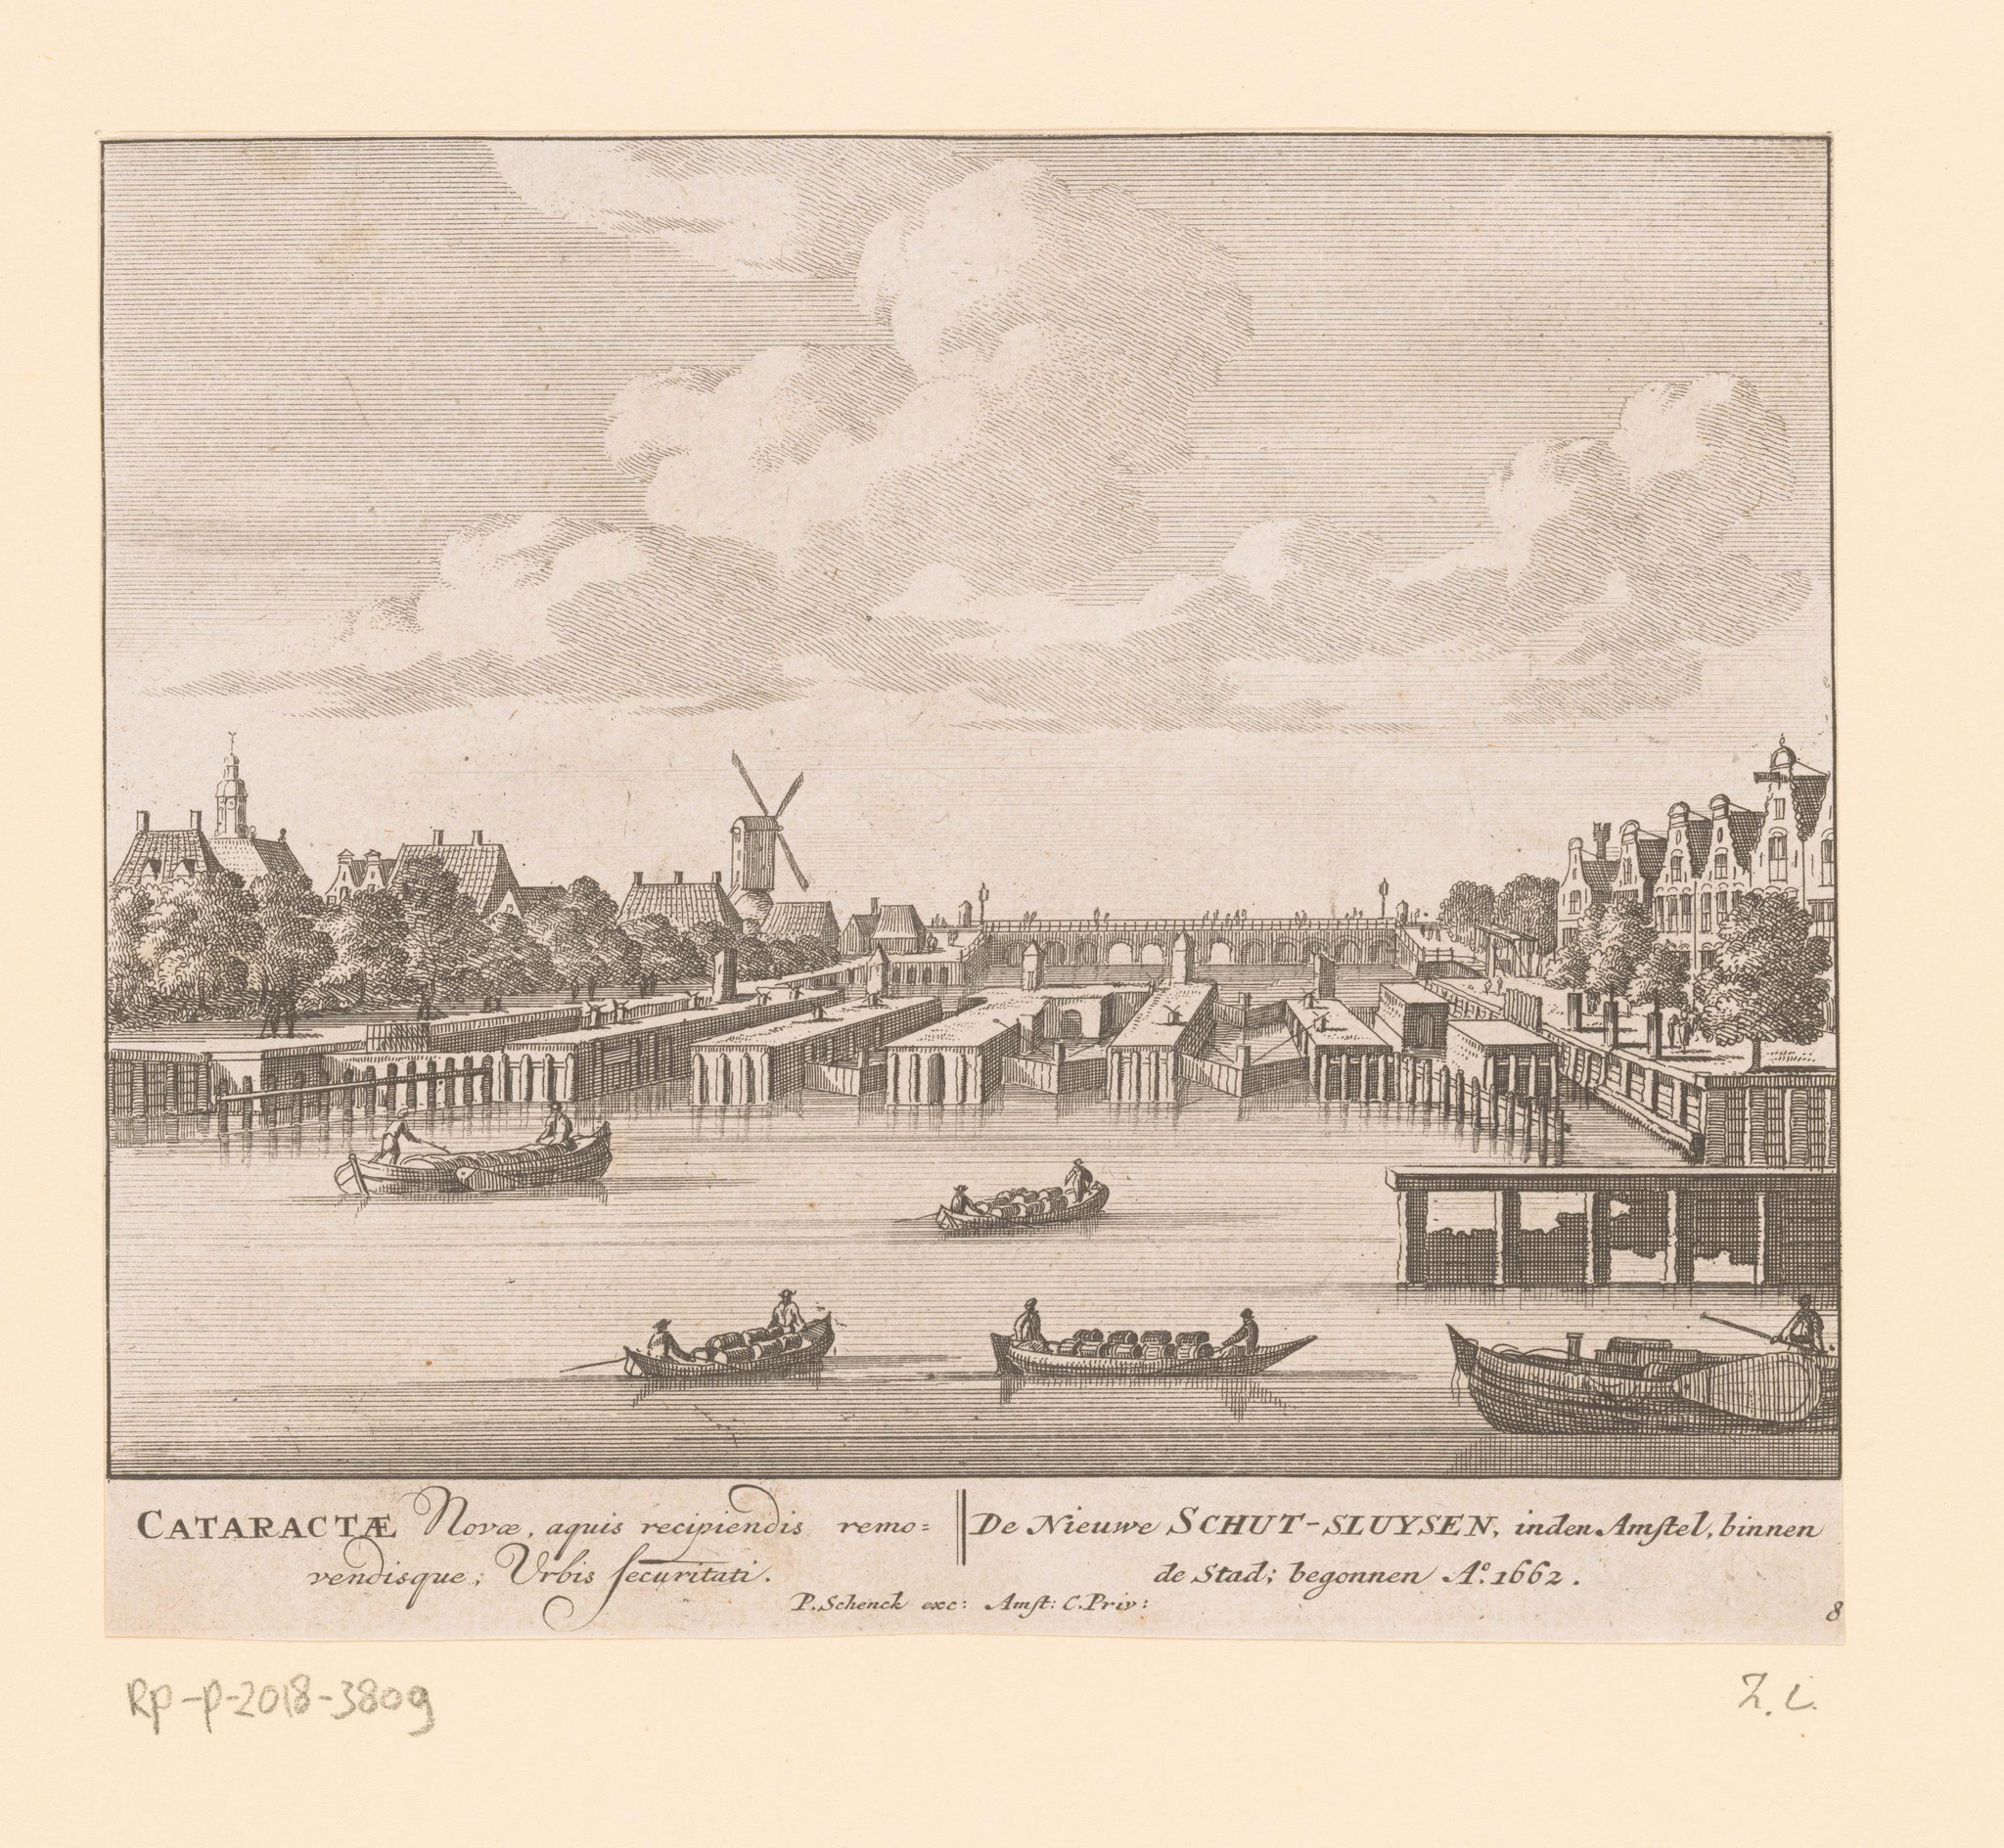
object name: print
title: Gezicht op de Binnen-Amstel en de Amstelsluizen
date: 1694-1697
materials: paper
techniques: etching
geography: amsterdam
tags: sluice, weir, city-view, and landscape with man-made constructions, canals, waters (in city)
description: Prent uit: Admirandorum Quadruplex Spectaculum. Amsterdam: Pieter Schenk (I), [1694-1697]. In Hollstein vermeld bij een serie van 100 prenten over Amsterdam, maar de prenten die in Hollstein worden genoemd zijn groter.